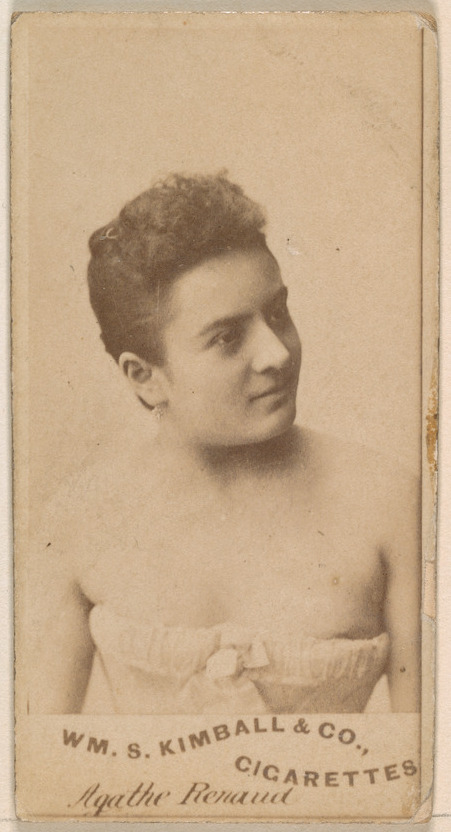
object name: photograph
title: Agathe Renaud, from the Actresses series (N203) issued by Wm. S. Kimball & Co.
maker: william s. kimball & company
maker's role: publisher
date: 1889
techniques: color lithograph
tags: portraits,women,actresses